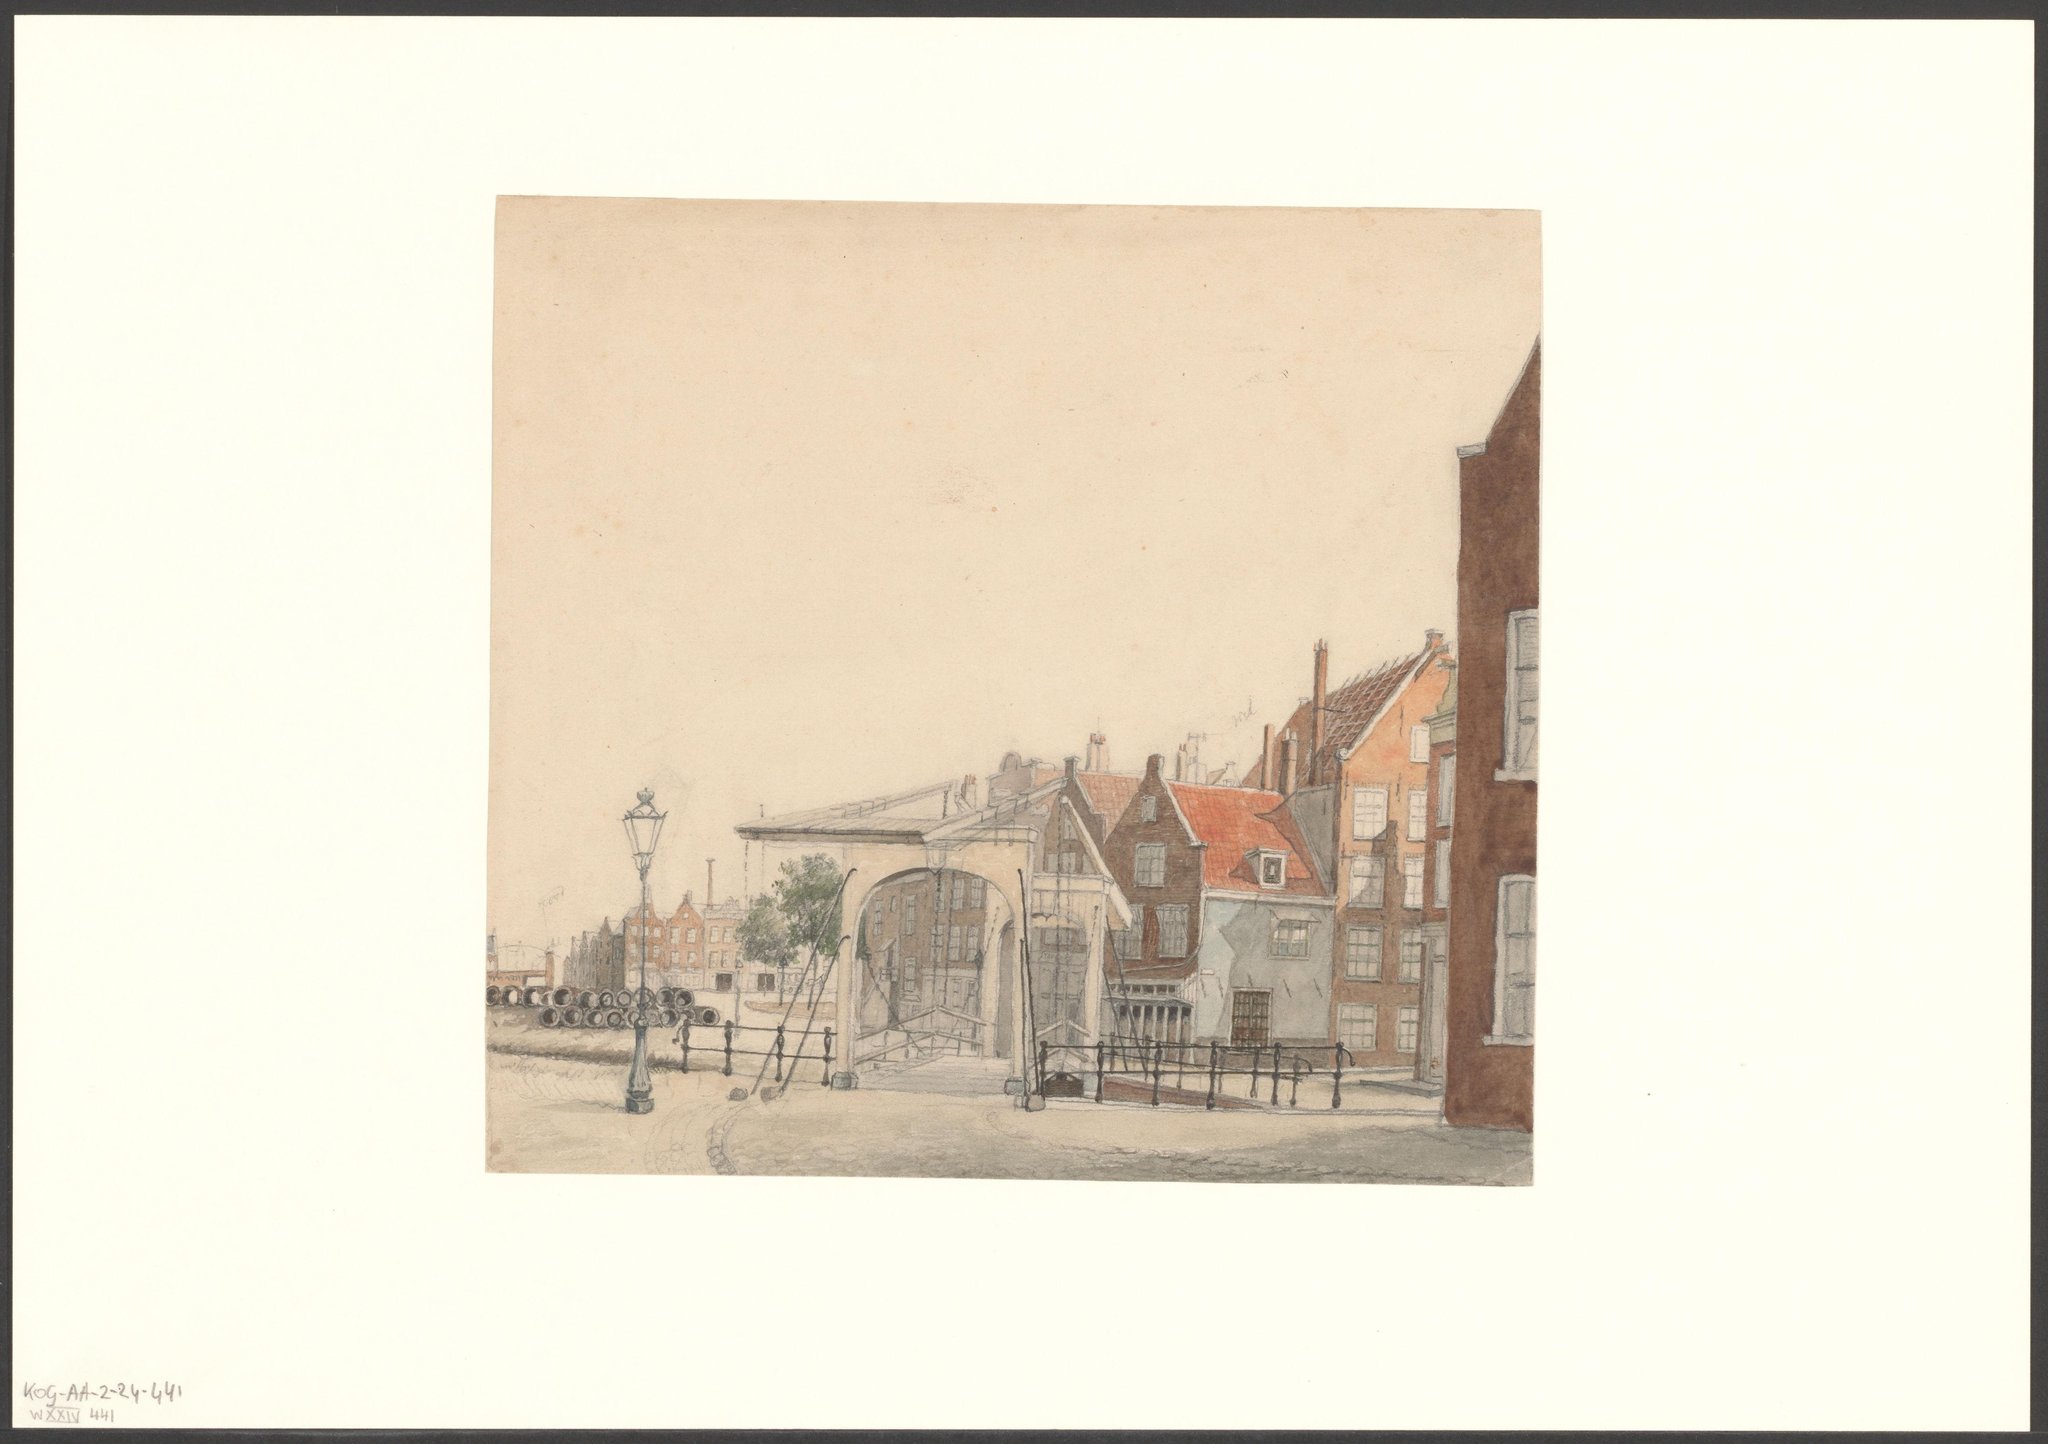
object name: drawing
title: Gezicht op de Bullebaksluis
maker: johan george lodewijk rieke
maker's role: draughtsman, print maker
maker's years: 1817-1898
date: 1886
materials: paper, pencil, watercolor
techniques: brush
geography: amsterdam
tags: city-view in general; 'veduta', bridge in city across river, canal, etc., street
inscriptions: date: ‘Bullebak 1886’, collector's mark: Lugt 1713a, inscription: ‘De Bullebakbrug bij het Haarlemmerplein’, signature: ‘naar de natuur geteekend door JGL Rieke’, number: ‘5/128’, collector's mark: Lugt 800a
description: Tekening binnen de Atlas Van Eck ingedeeld op wijknummer 24.